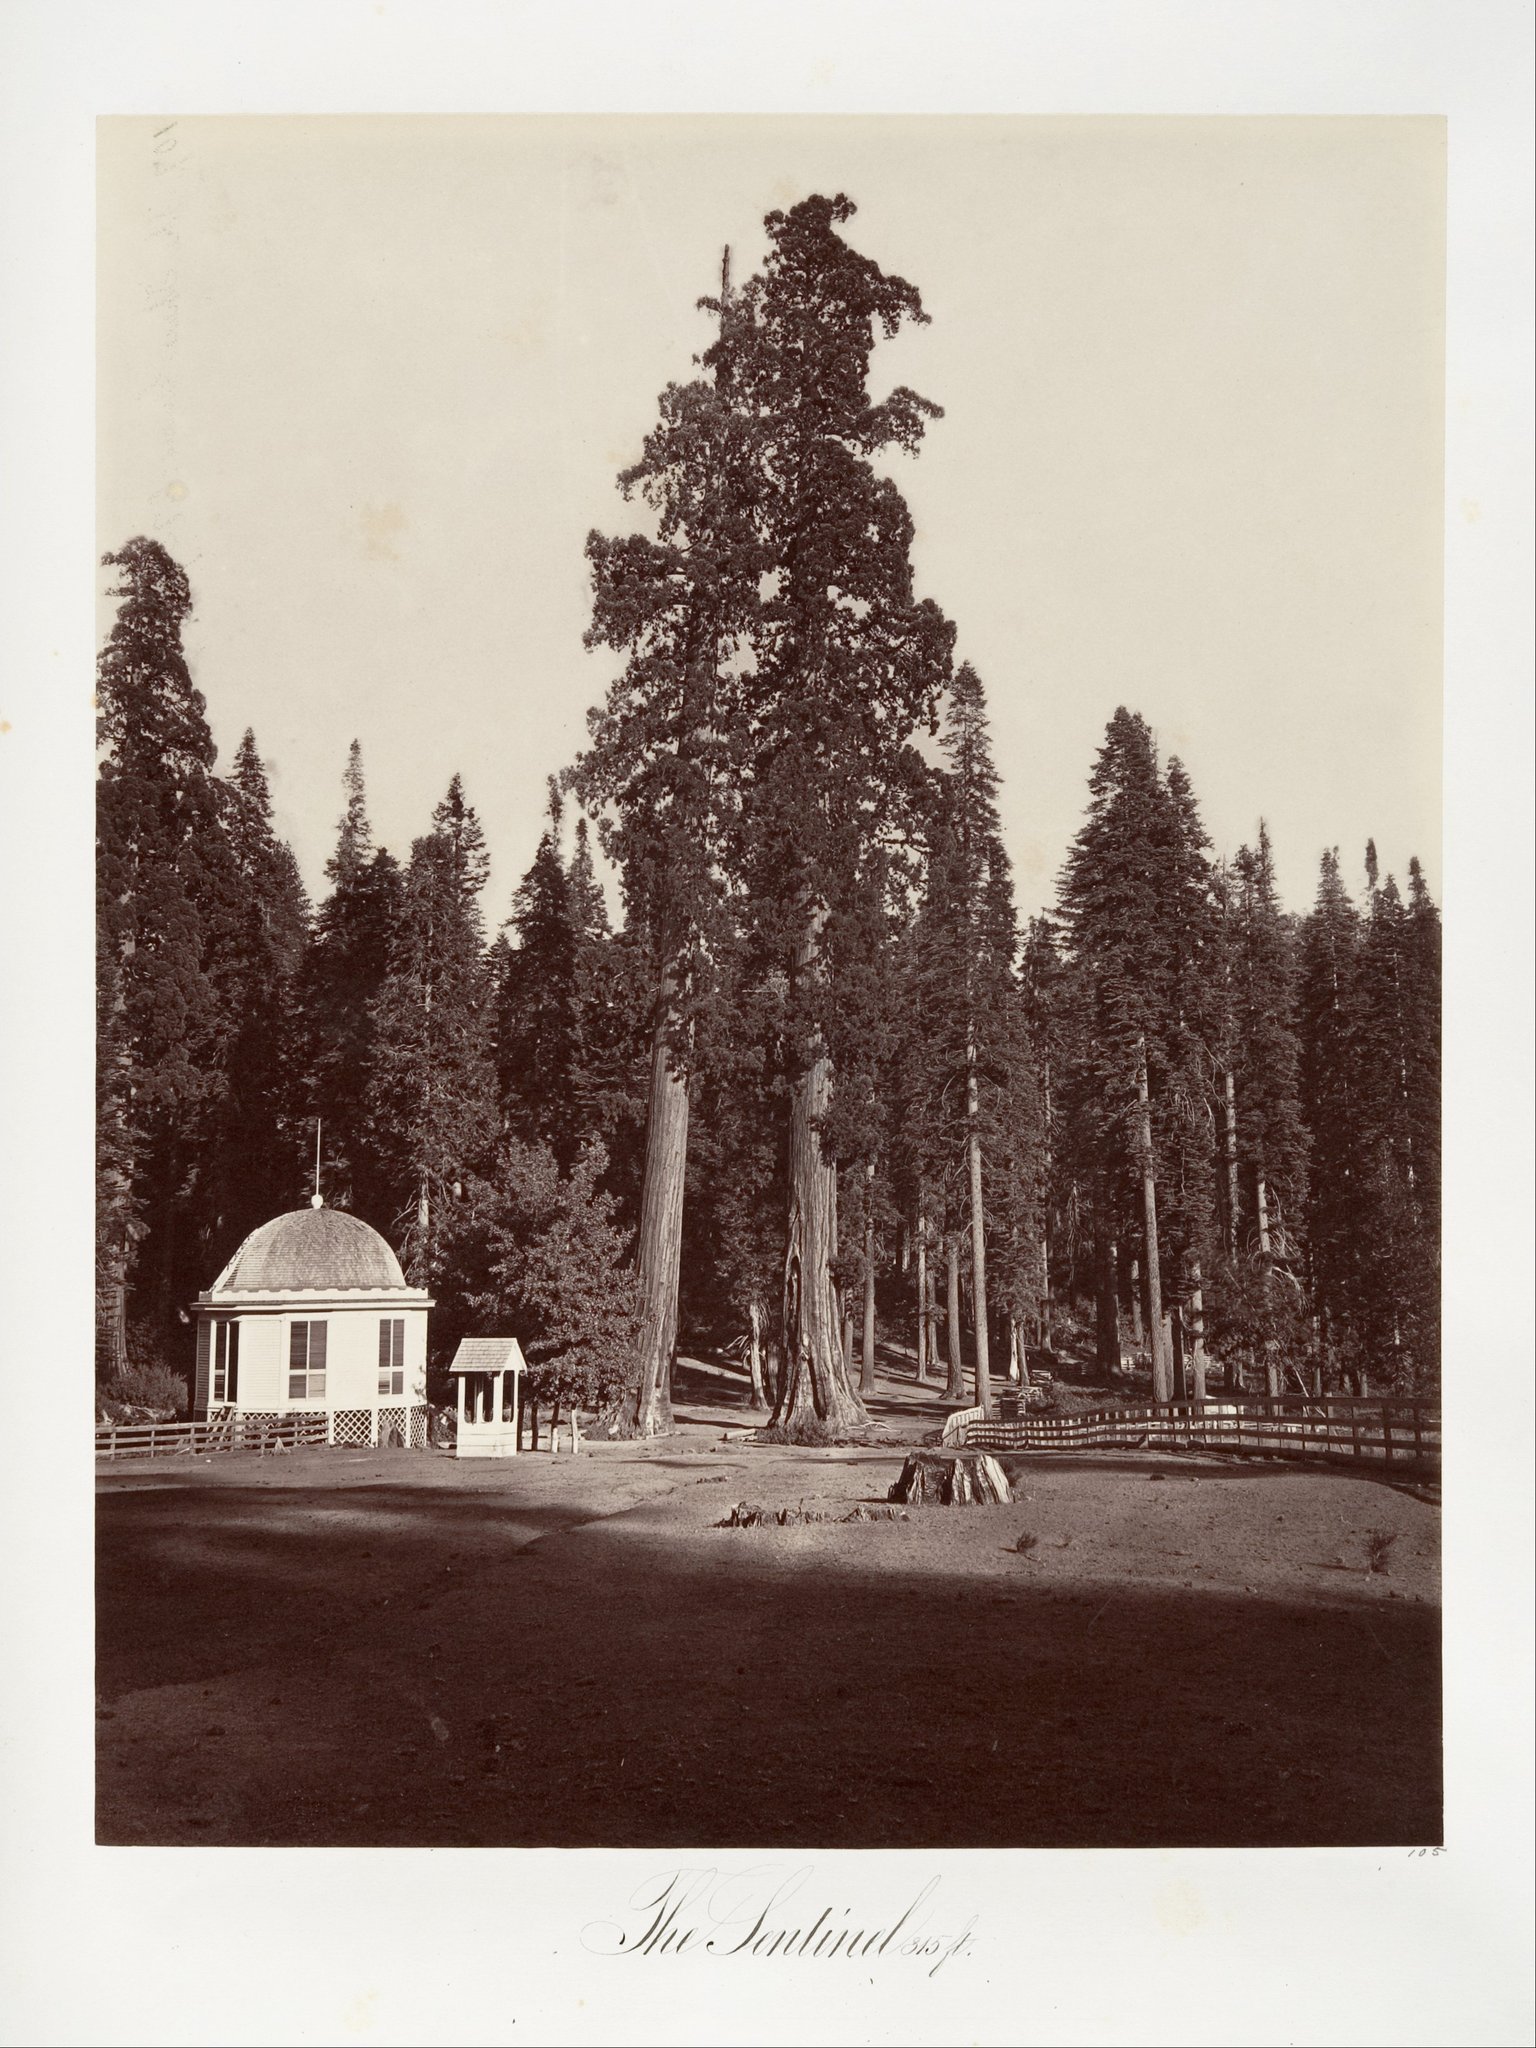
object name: photograph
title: The Sentinel, 315 feet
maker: carleton e. watkins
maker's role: artist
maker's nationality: american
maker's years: 1829-1916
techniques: albumen silver print, glass negative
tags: architecture,forests